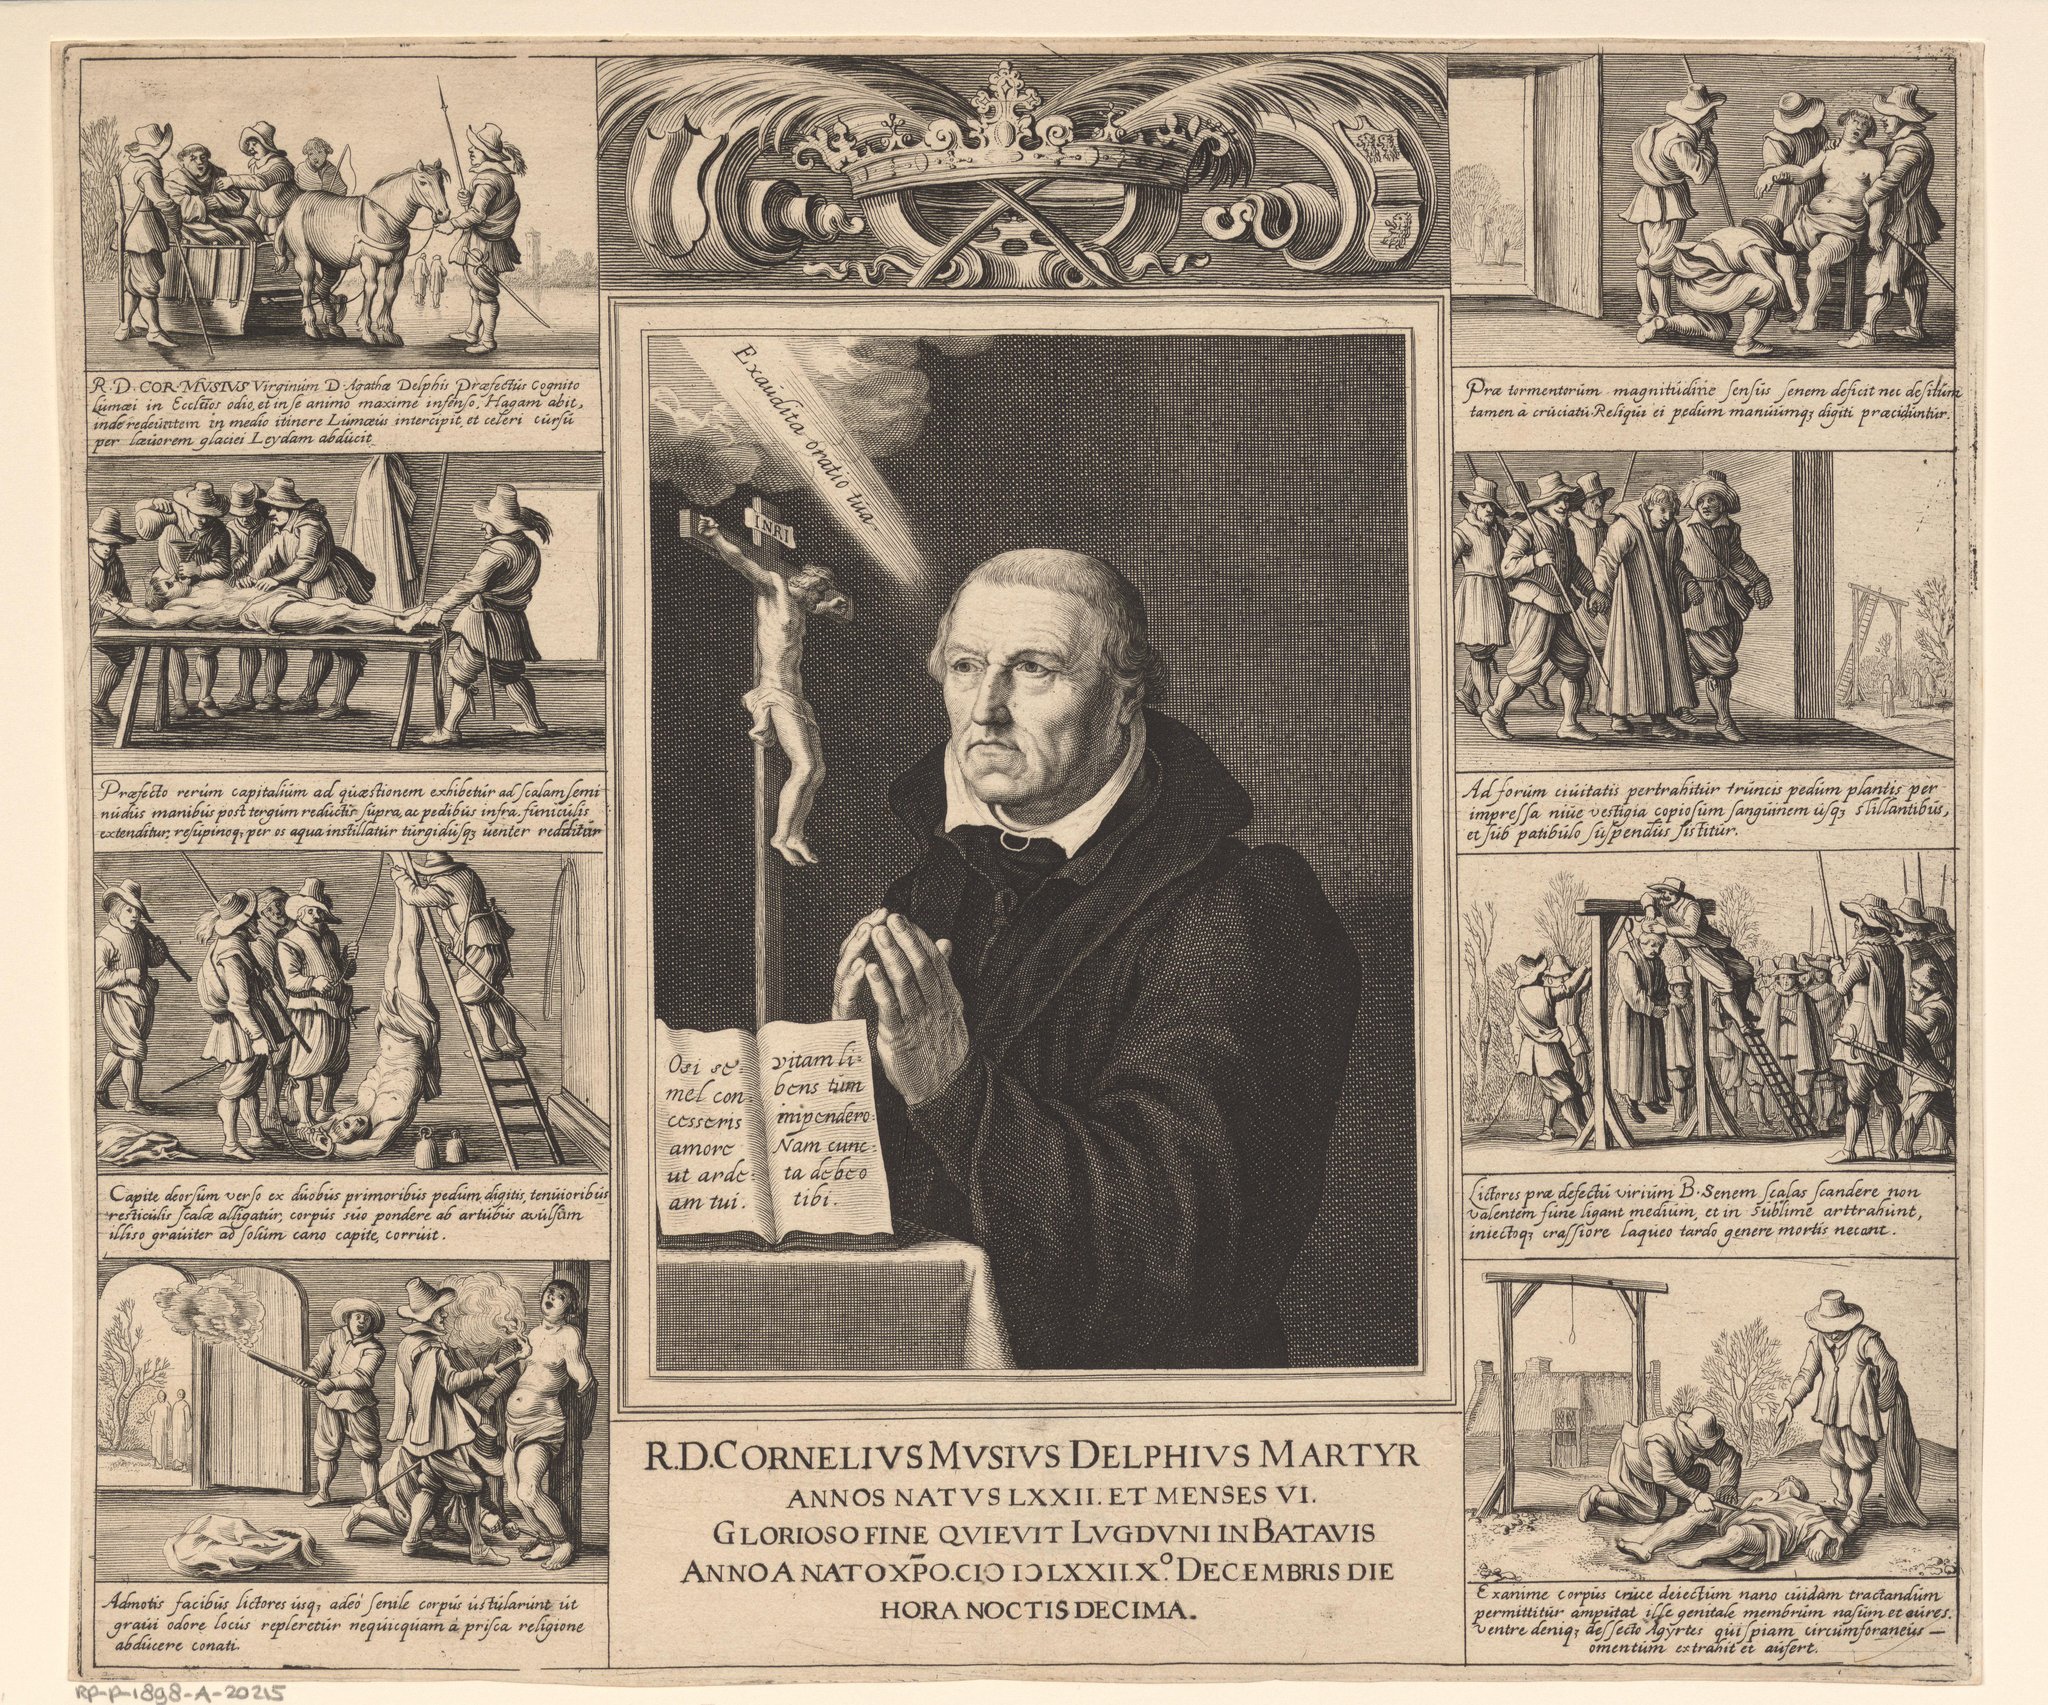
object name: print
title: Portret van Cornelis Musius, met scènes van zijn martelaarschap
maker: jan van de velde (ii)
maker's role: draughtsman, painter, print maker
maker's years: 1593-1641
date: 1614-1641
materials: paper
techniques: engraving, etching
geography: northern netherlands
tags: delft, leiden, priest, cornelis musius, violent death ~ maltreatment, torture, mutilation of the corpse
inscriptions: collector's mark: Lugt 964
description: Portret van de predikant Cornelis Musius (1500-1572), knielend voor een crucifix dat voor hem op een tafel staat. Uit de hemel een lichtstraal met de tekst: Exaudita oratio tua. Portret omgeven door 8 kleine voorstellingen met zijn martelaarschap. Middenboven een kroon. Musius was pastoor van het St. Agathaklooster in Delft. In 1572 werd hij opgehangen nadat hij eerst door protestantse fanatici (Geuzen) was gemarteld.